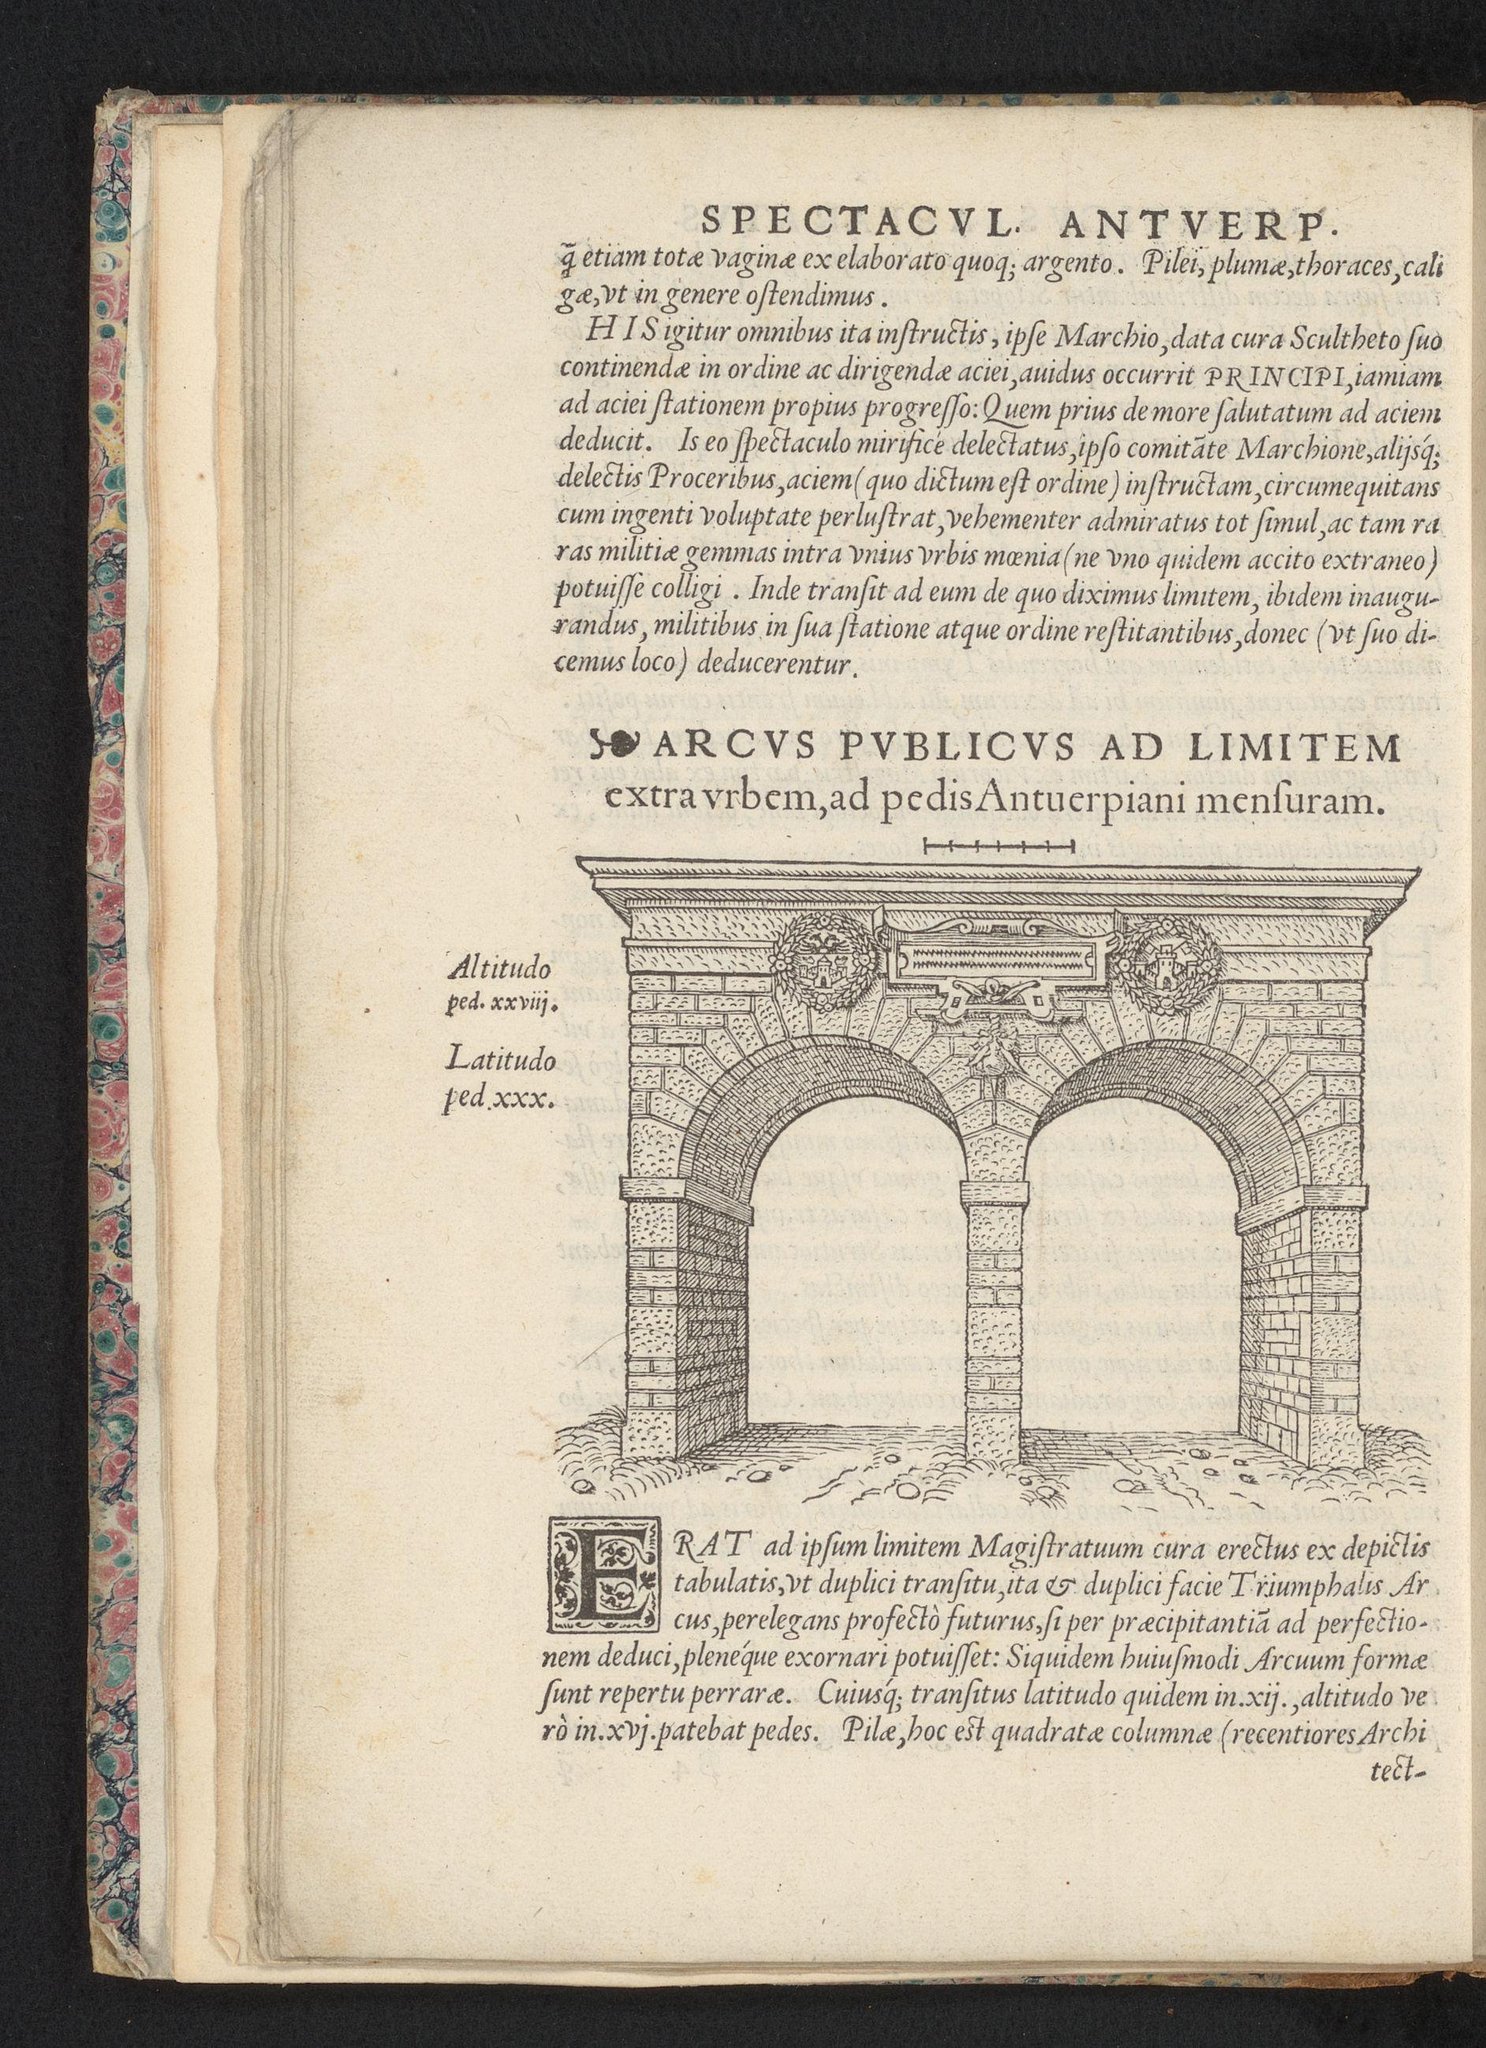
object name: print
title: Arcus Publicus ad limitem extra urbem, ad pedis Antverpianai mensuram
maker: pieter coecke van aelst (i)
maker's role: draughtsman, print maker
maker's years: 1502-1550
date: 1549-1550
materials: paper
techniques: woodcut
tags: philip ii of spain, triumphal arch, antwerp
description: Illustratie in de Spectaculorum in susceptione Philippi Hisp. Prin. Divi Caroli. V. Caes. F. ann 1549 Antverpiae aeditorum, mirificus apparatus. Tekst van Cornelius Grapheus, opgedragen aan Filips II, uitgegeven met keizerlijke privilege door Pieter Coecke van Aelst, gedrukt door Gillis van Diest. Boek in de bibliotheek met signatuur: 325 B 13.